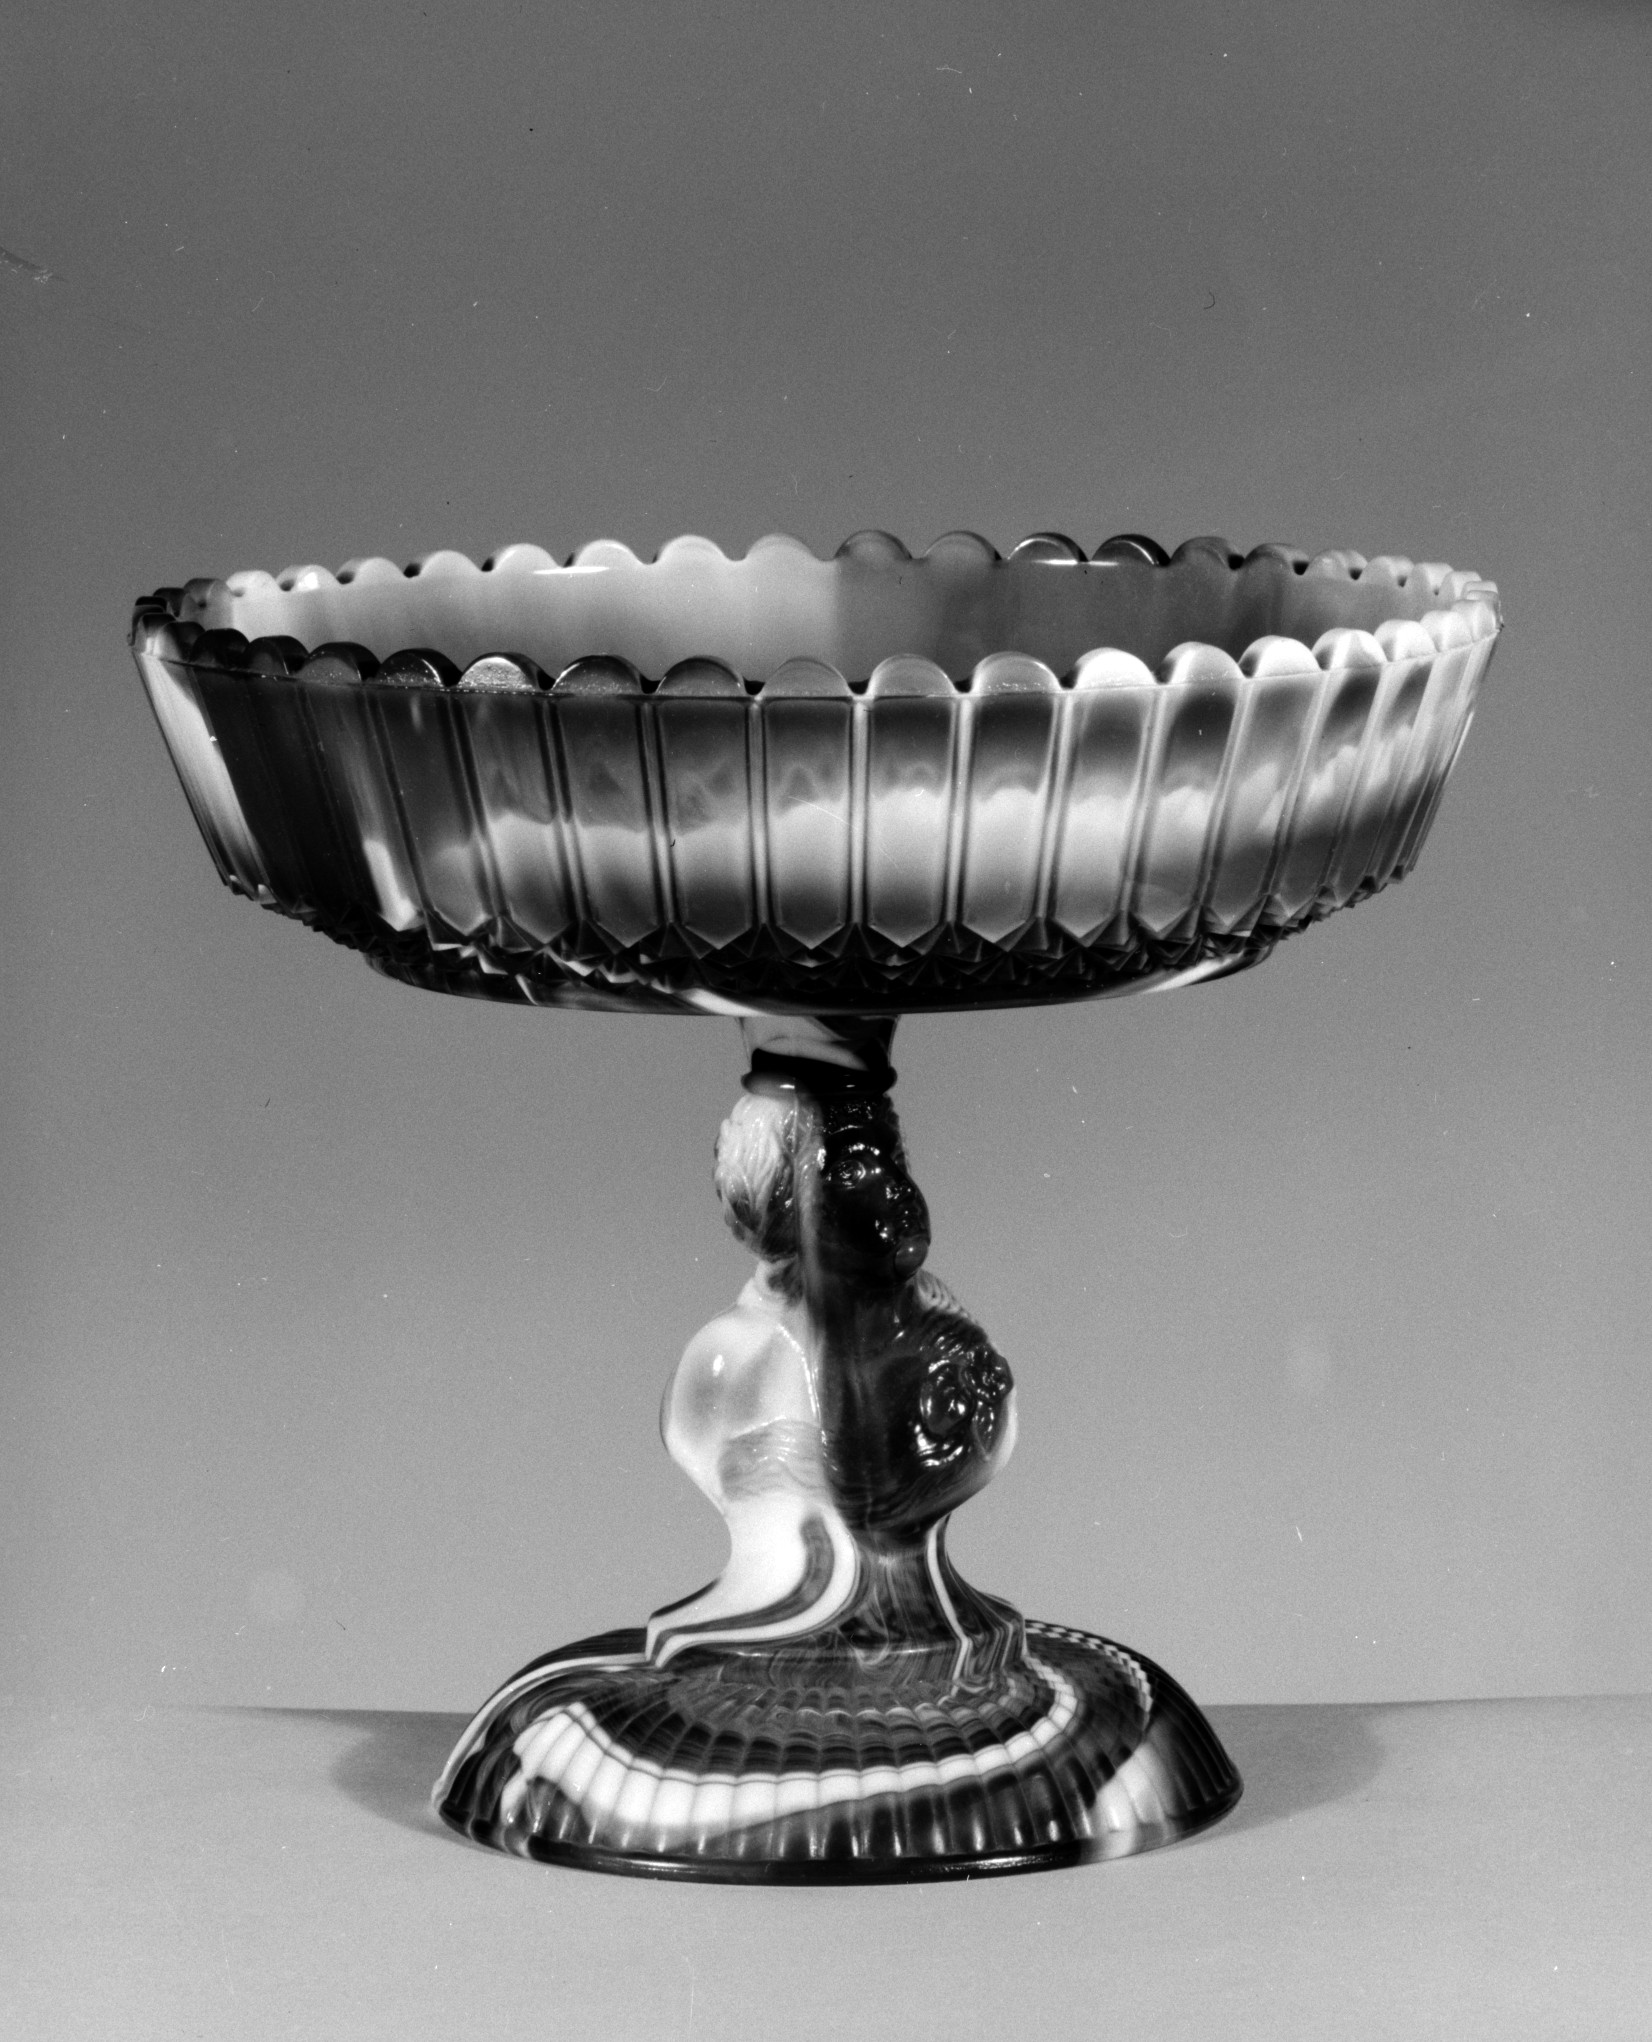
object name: compote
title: Purple marble glass compote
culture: american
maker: challinor, taylor and company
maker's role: maker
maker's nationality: american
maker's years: 1866-1891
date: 1870-1890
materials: glass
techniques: pressed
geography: united states